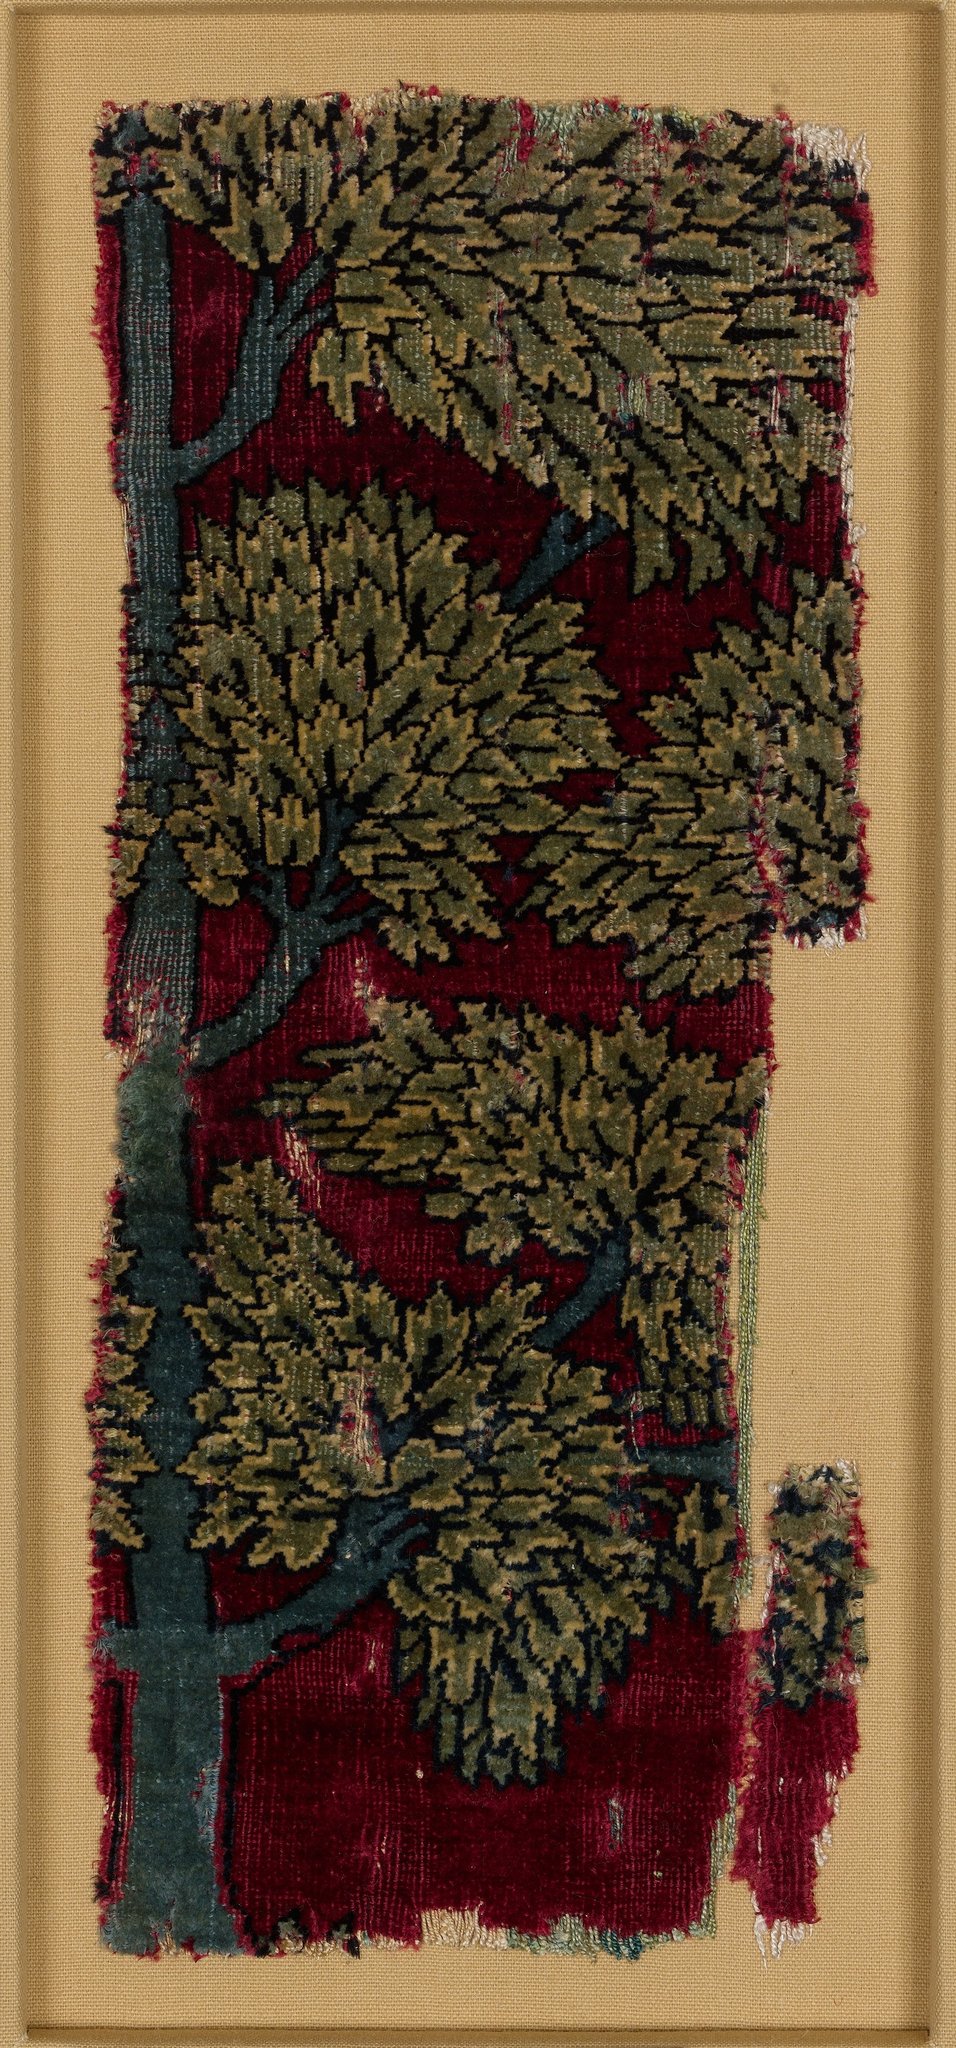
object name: carpet fragment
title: Pashmina Carpet Fragment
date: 1601-1650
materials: silk, wool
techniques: asymmetrically knotted pile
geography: northern india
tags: trees